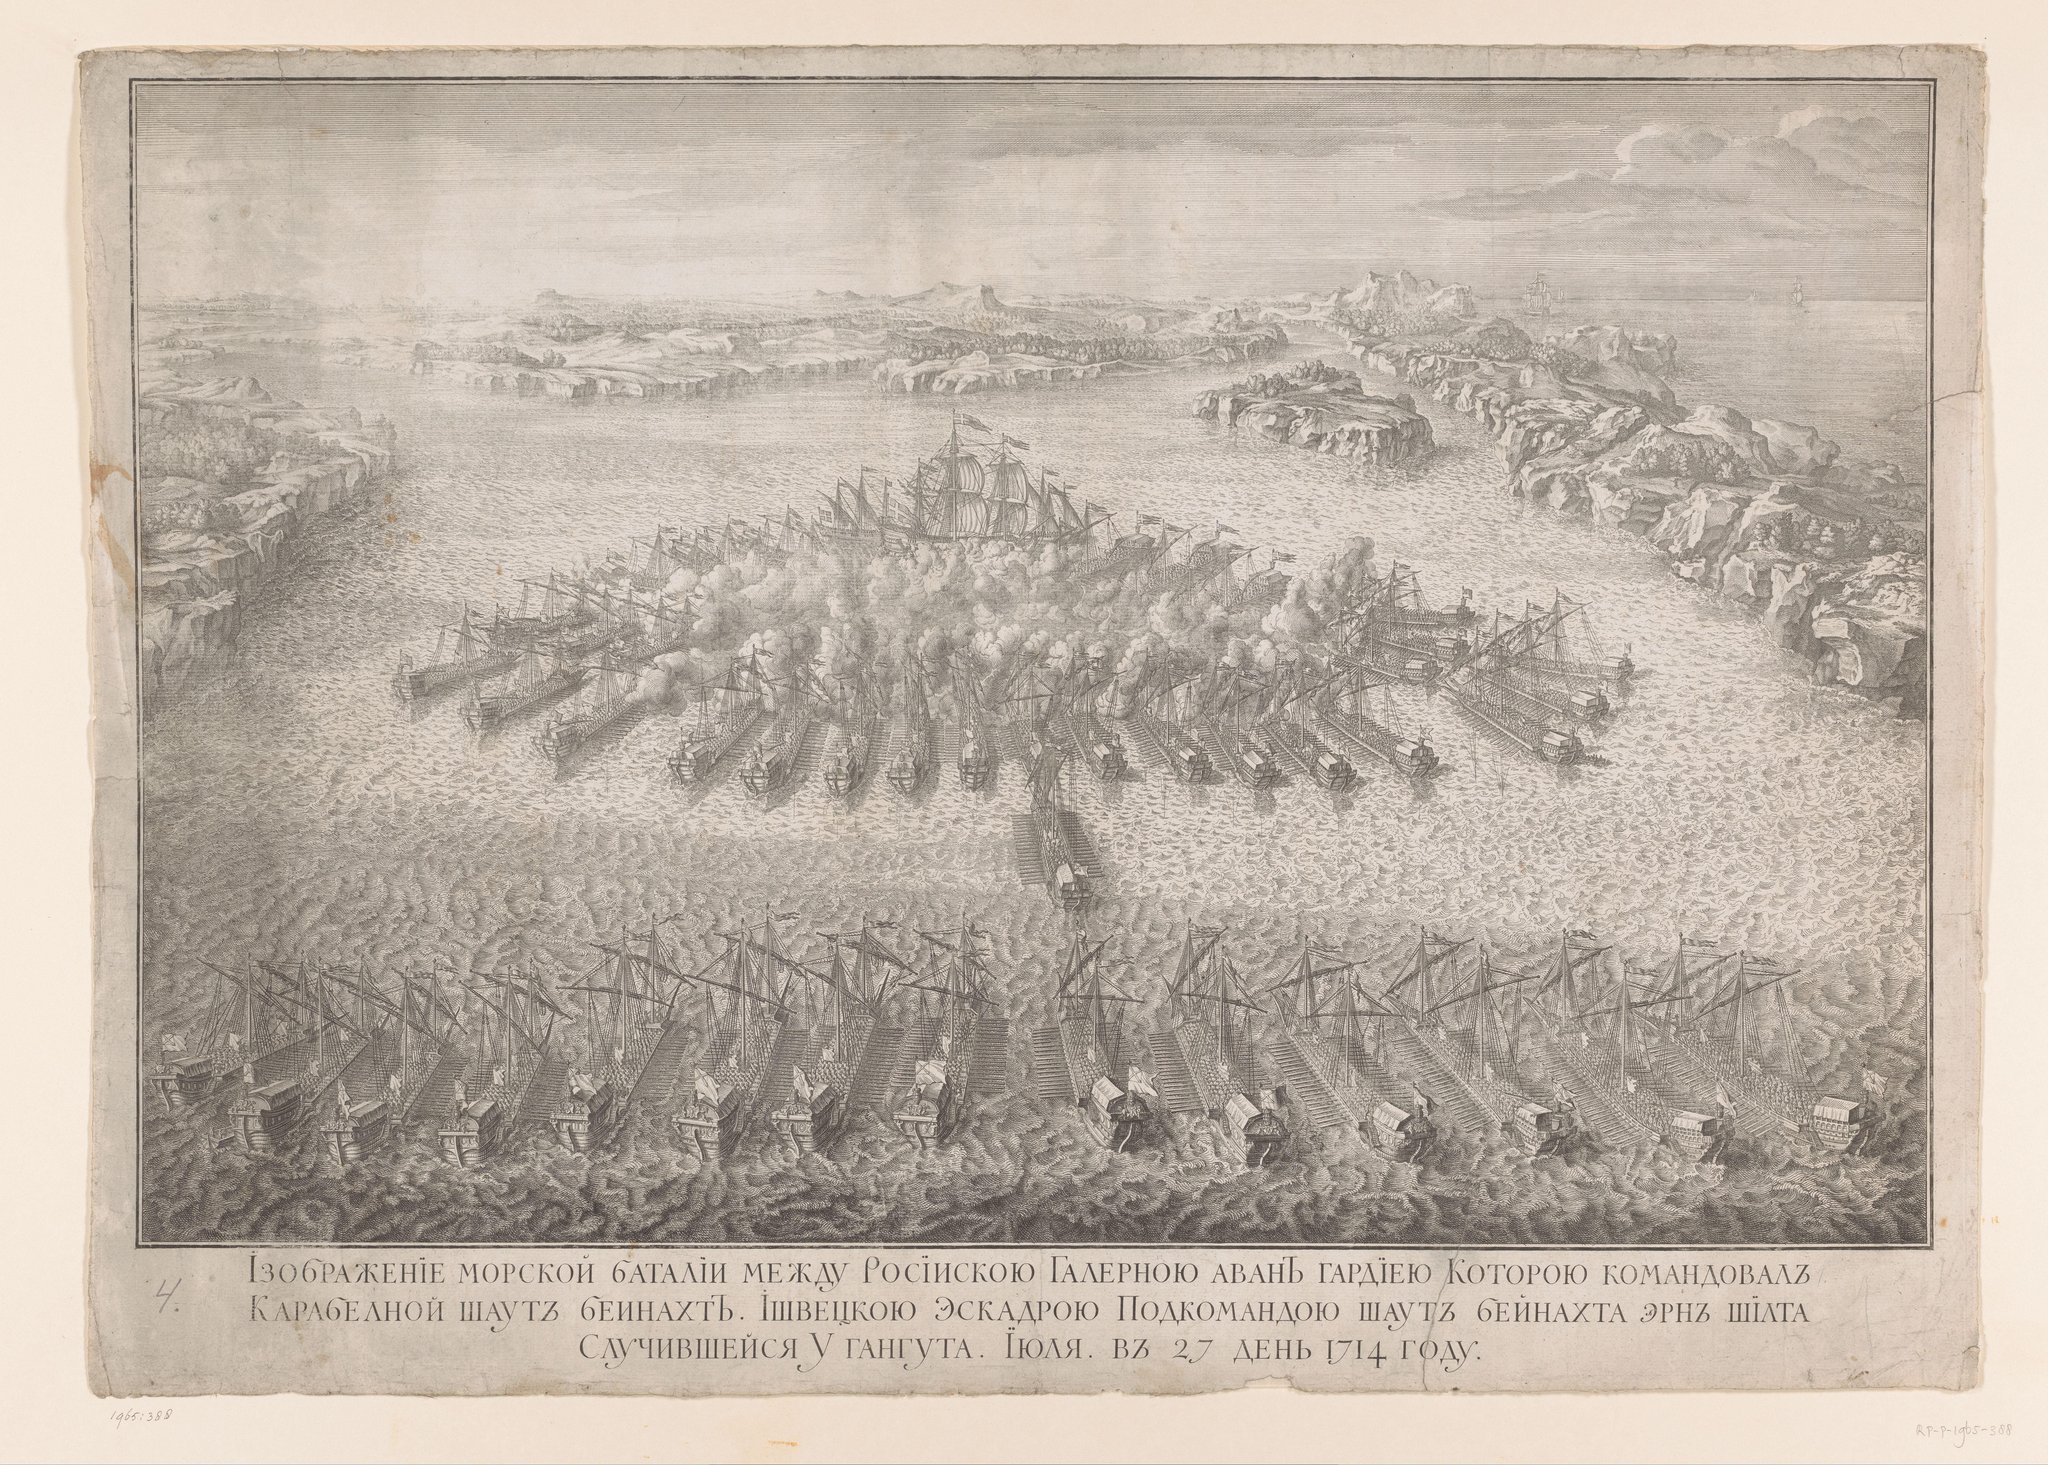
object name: print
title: Vier Russische prenten van confrontaties met de Zweden tijdens de Grote Noordse Oorlog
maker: maurice baquoy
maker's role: print maker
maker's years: 1680-1747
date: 1709-1747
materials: paper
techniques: engraving, etching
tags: battle (+ sailing-ships)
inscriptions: collector's mark: Lugt 2228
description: Zeeslag bij Hangö (Gangut), (27 juli) 7 augustus 1714. Zeeslag tussen de Russische en Zweedse vloot. Onderdeel van de Grote Noordse Oorlog. Met drieregelig onderschrift in Russisch Cyrillisch.